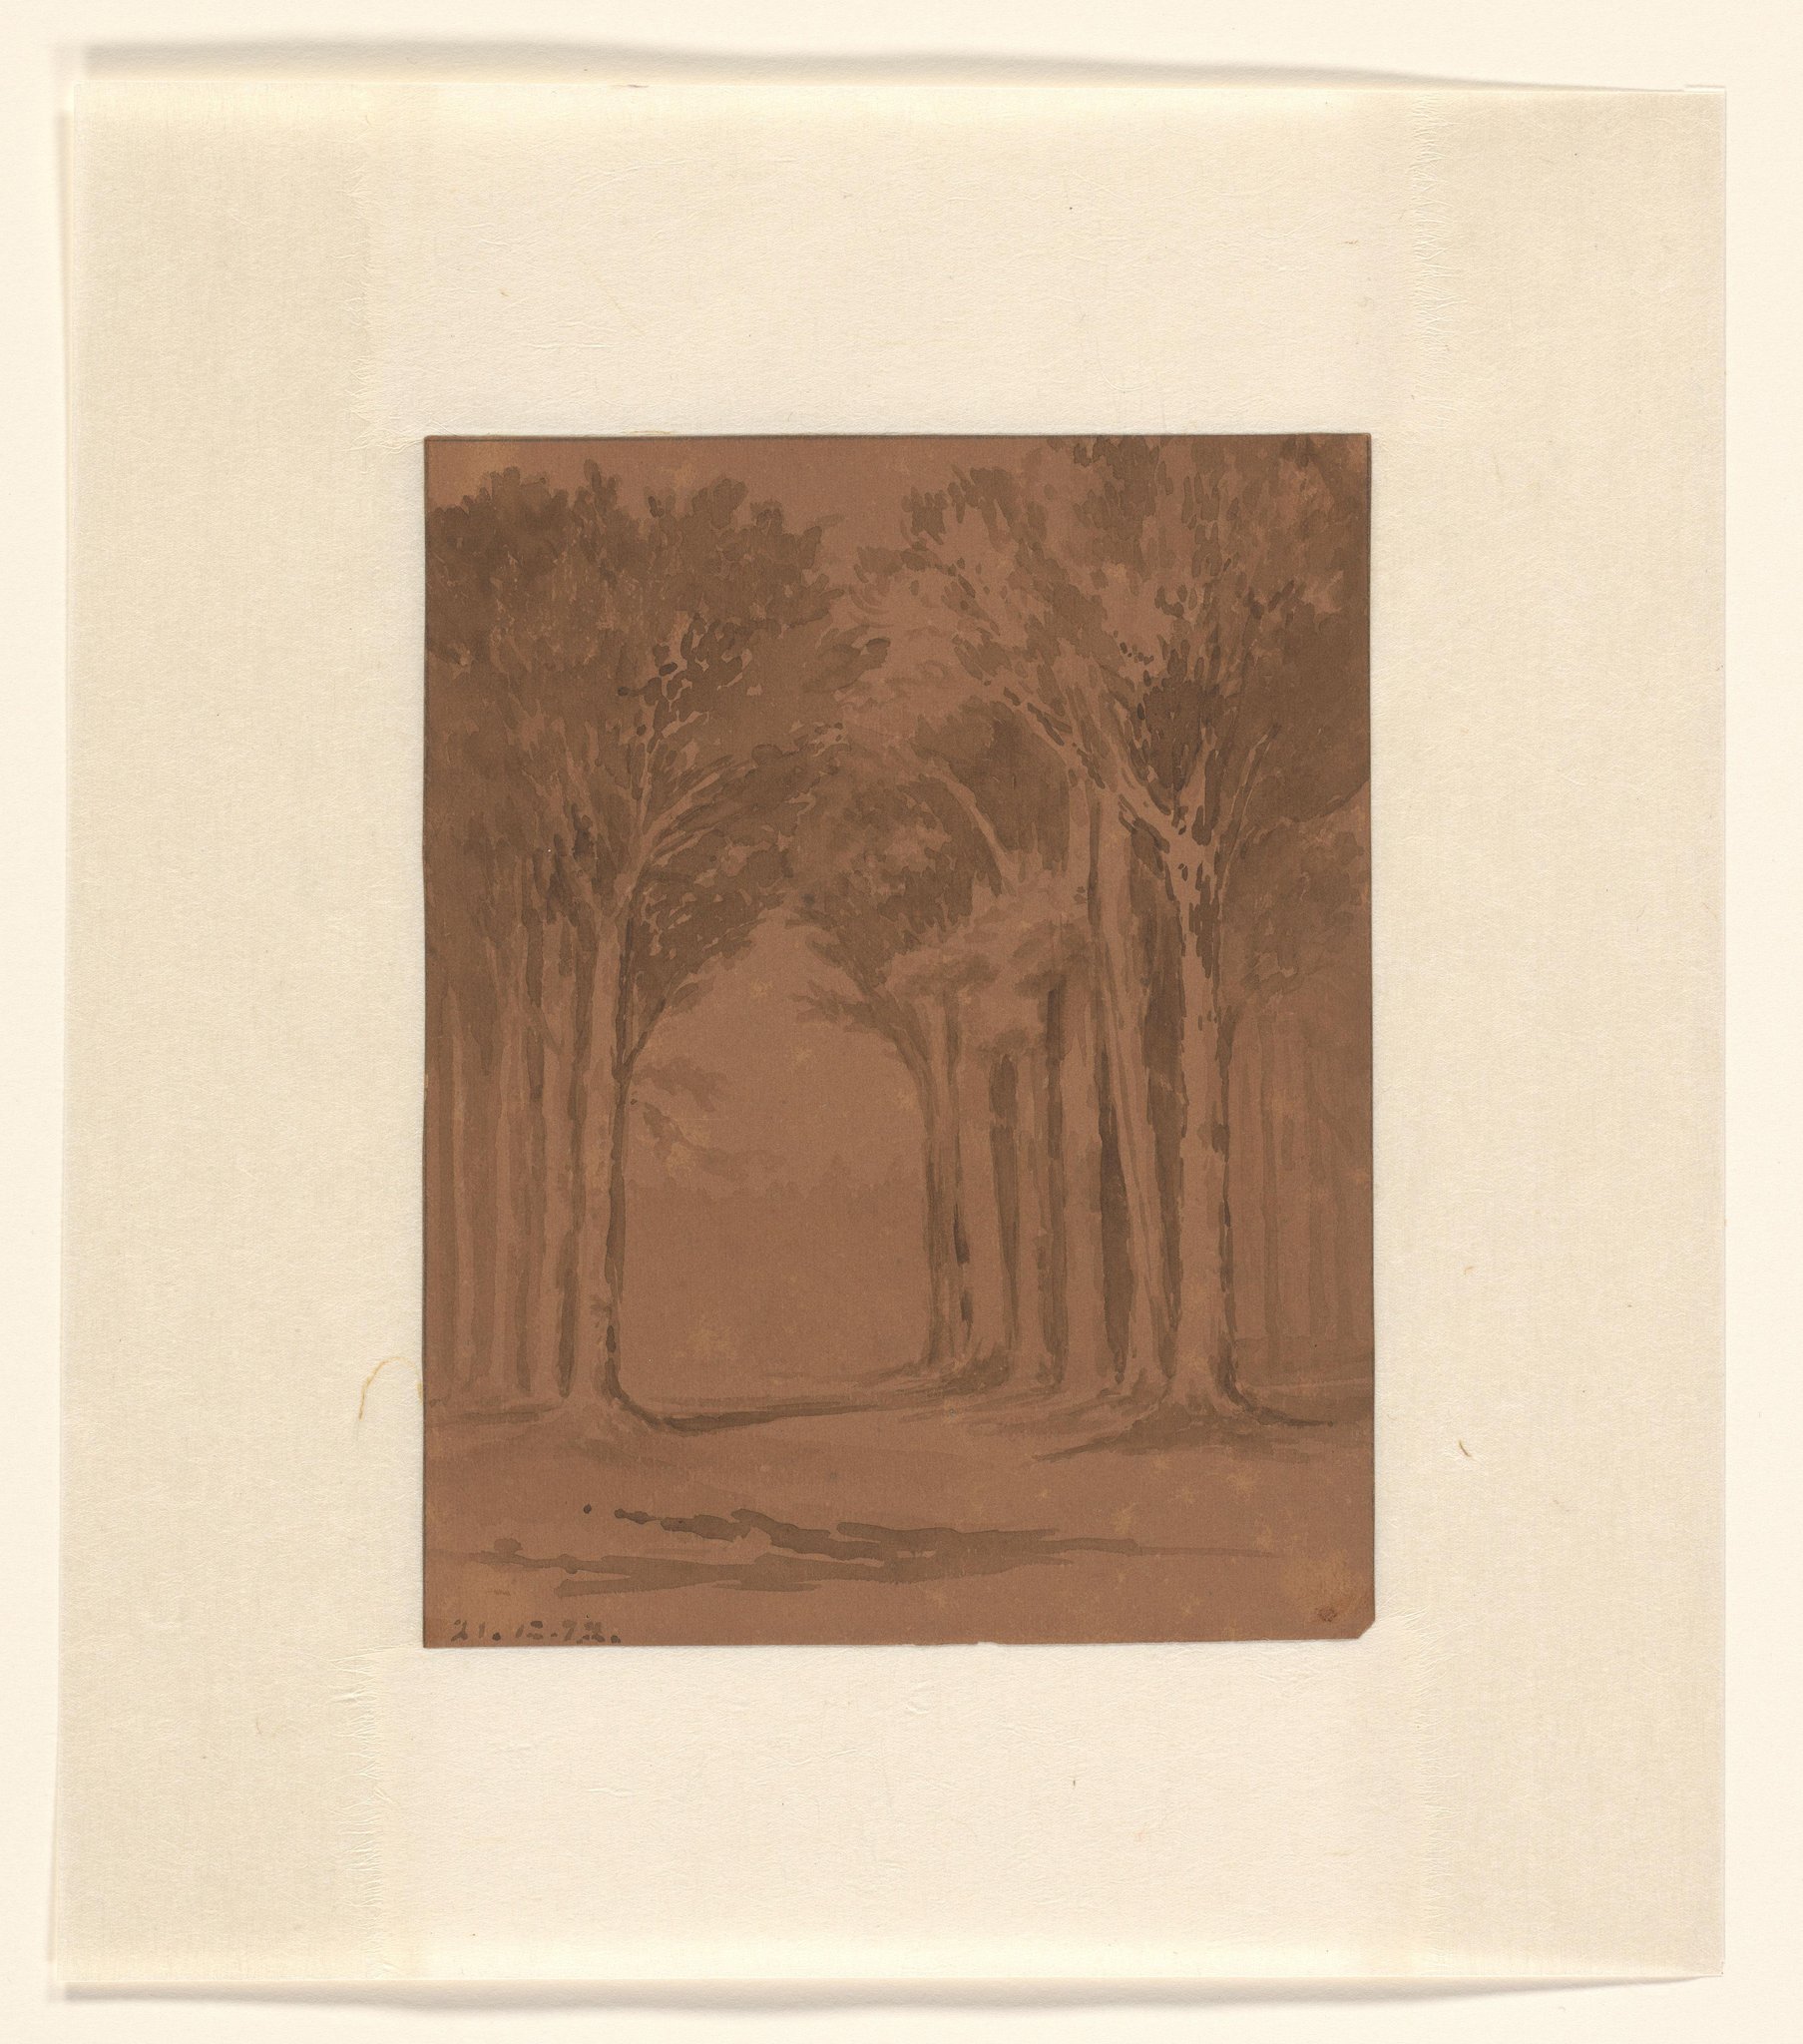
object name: drawing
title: Bomenlaan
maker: louis charles hora siccama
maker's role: draughtsman, print maker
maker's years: 1807-1880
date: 1872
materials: ink, paper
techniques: brush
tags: forest, wood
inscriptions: date